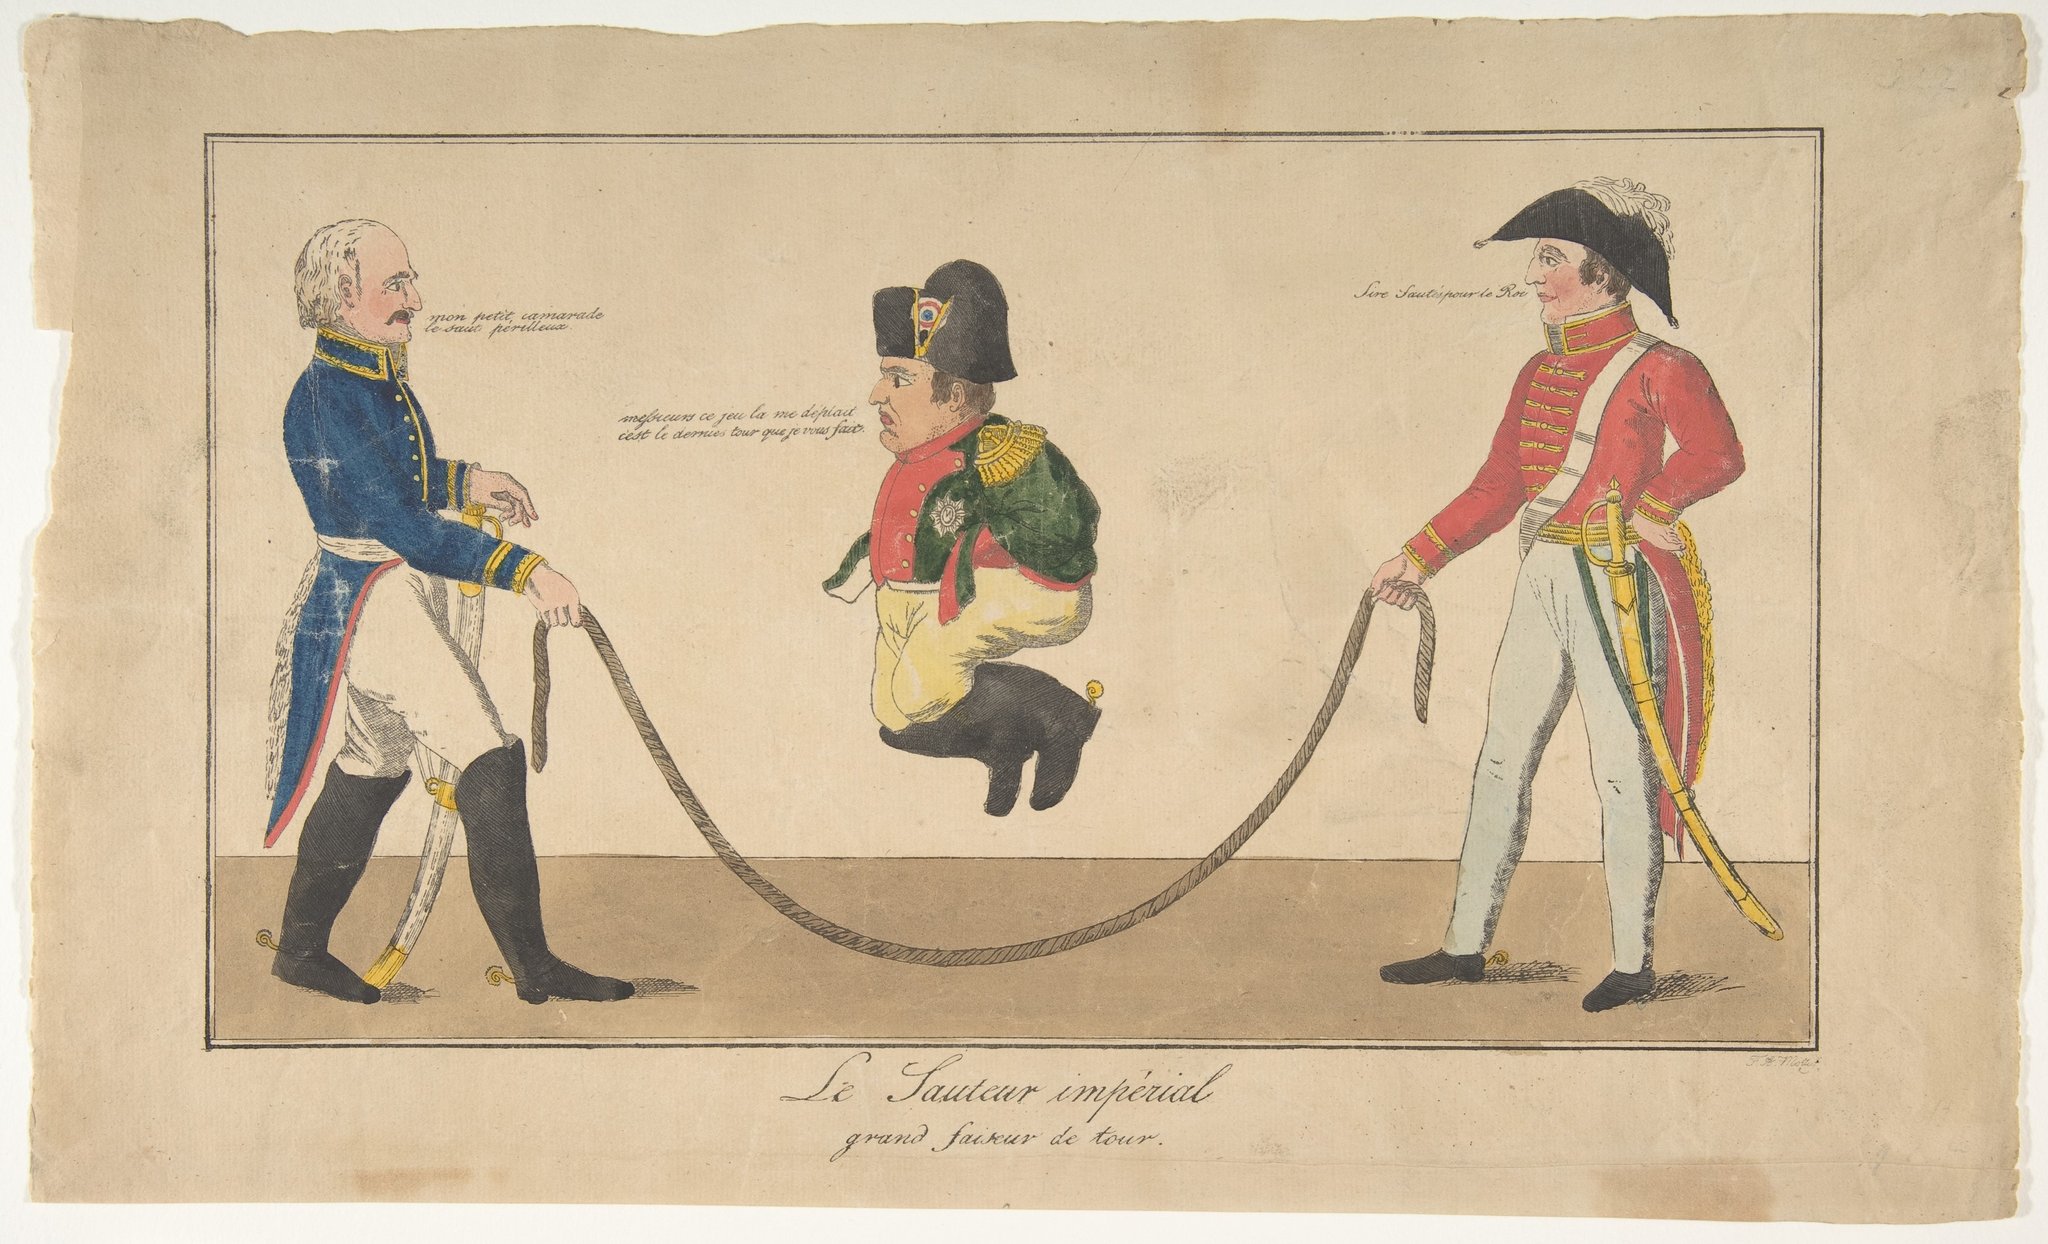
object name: print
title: Imperial Jump-rope (Le Sauteur impérial, grand faiseur de tour)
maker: friedrich august mottu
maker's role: artist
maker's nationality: german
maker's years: 1810-1815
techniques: hand coloring, lithograph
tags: men